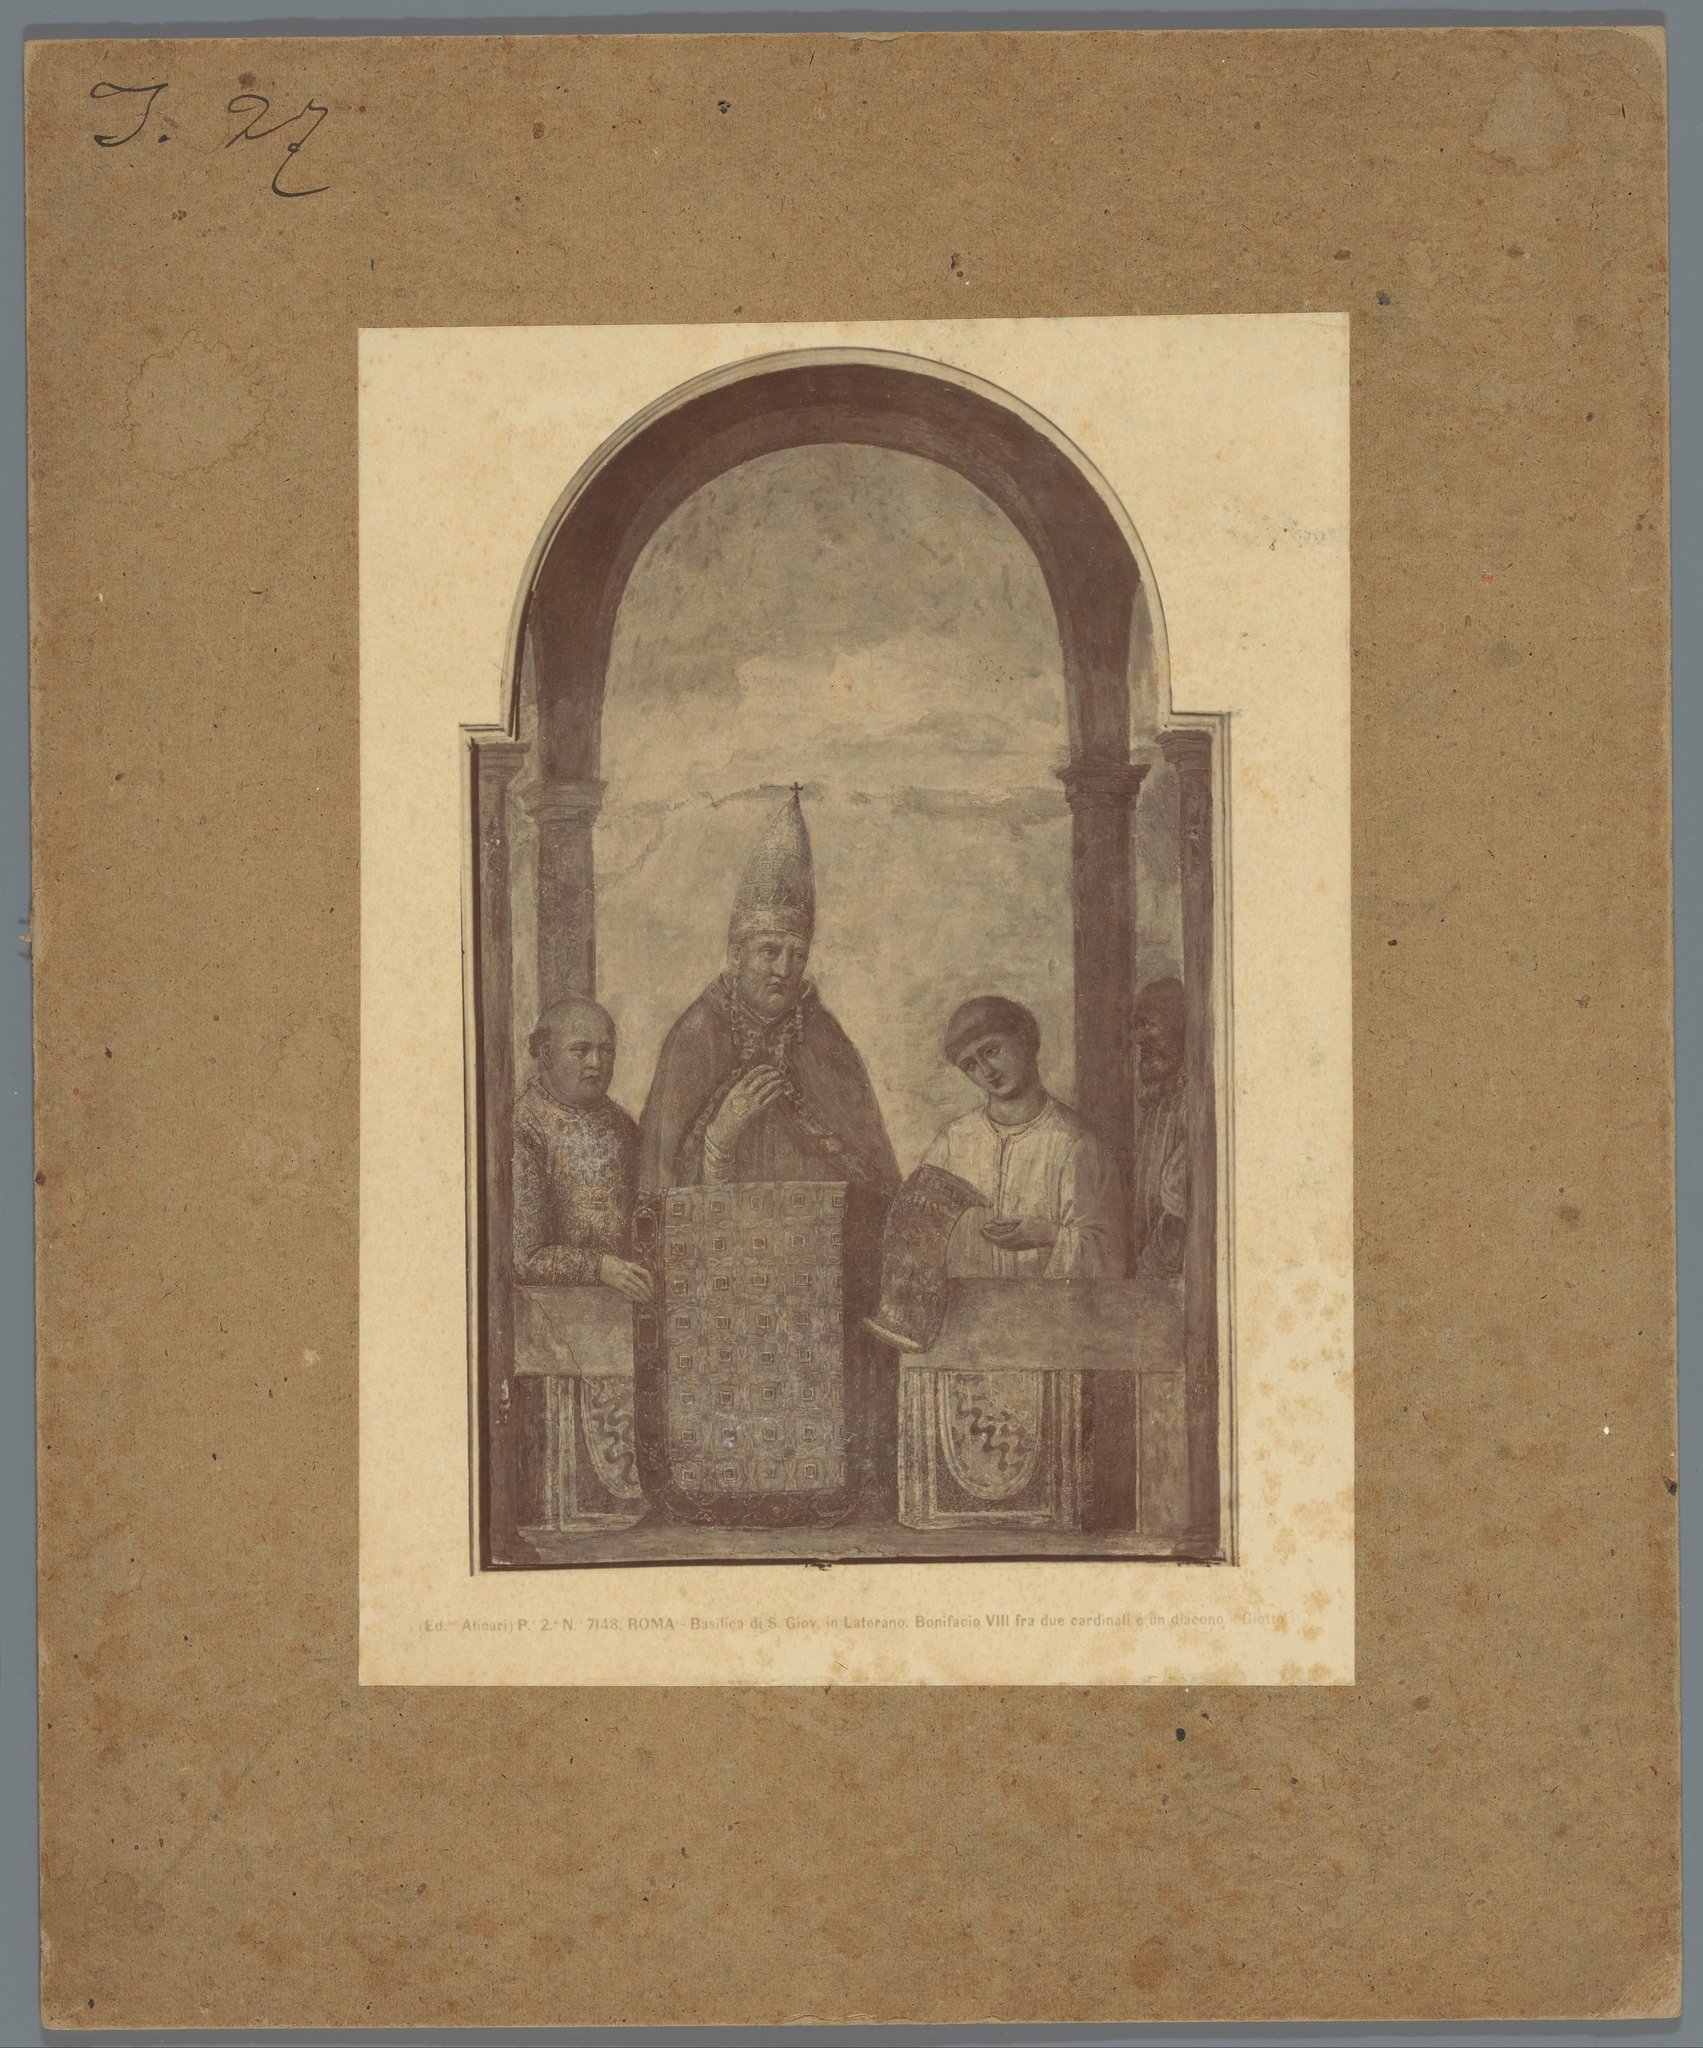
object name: photograph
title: Fotoreproductie van een fresco door Giotto, voorstellende paus Bonifatius VIII met twee kardinalen en een diaken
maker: giotto de bondone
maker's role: painter, sculptor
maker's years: 1266-1337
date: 1875-1900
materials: cardboard, photographic support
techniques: albumen print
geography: sint-jan van lateranen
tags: cardinal, deacon (roman catholic), pope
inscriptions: collector's mark: Lugt 3937, number: ‘P.e 2.a N.o 7148.’, annotation: